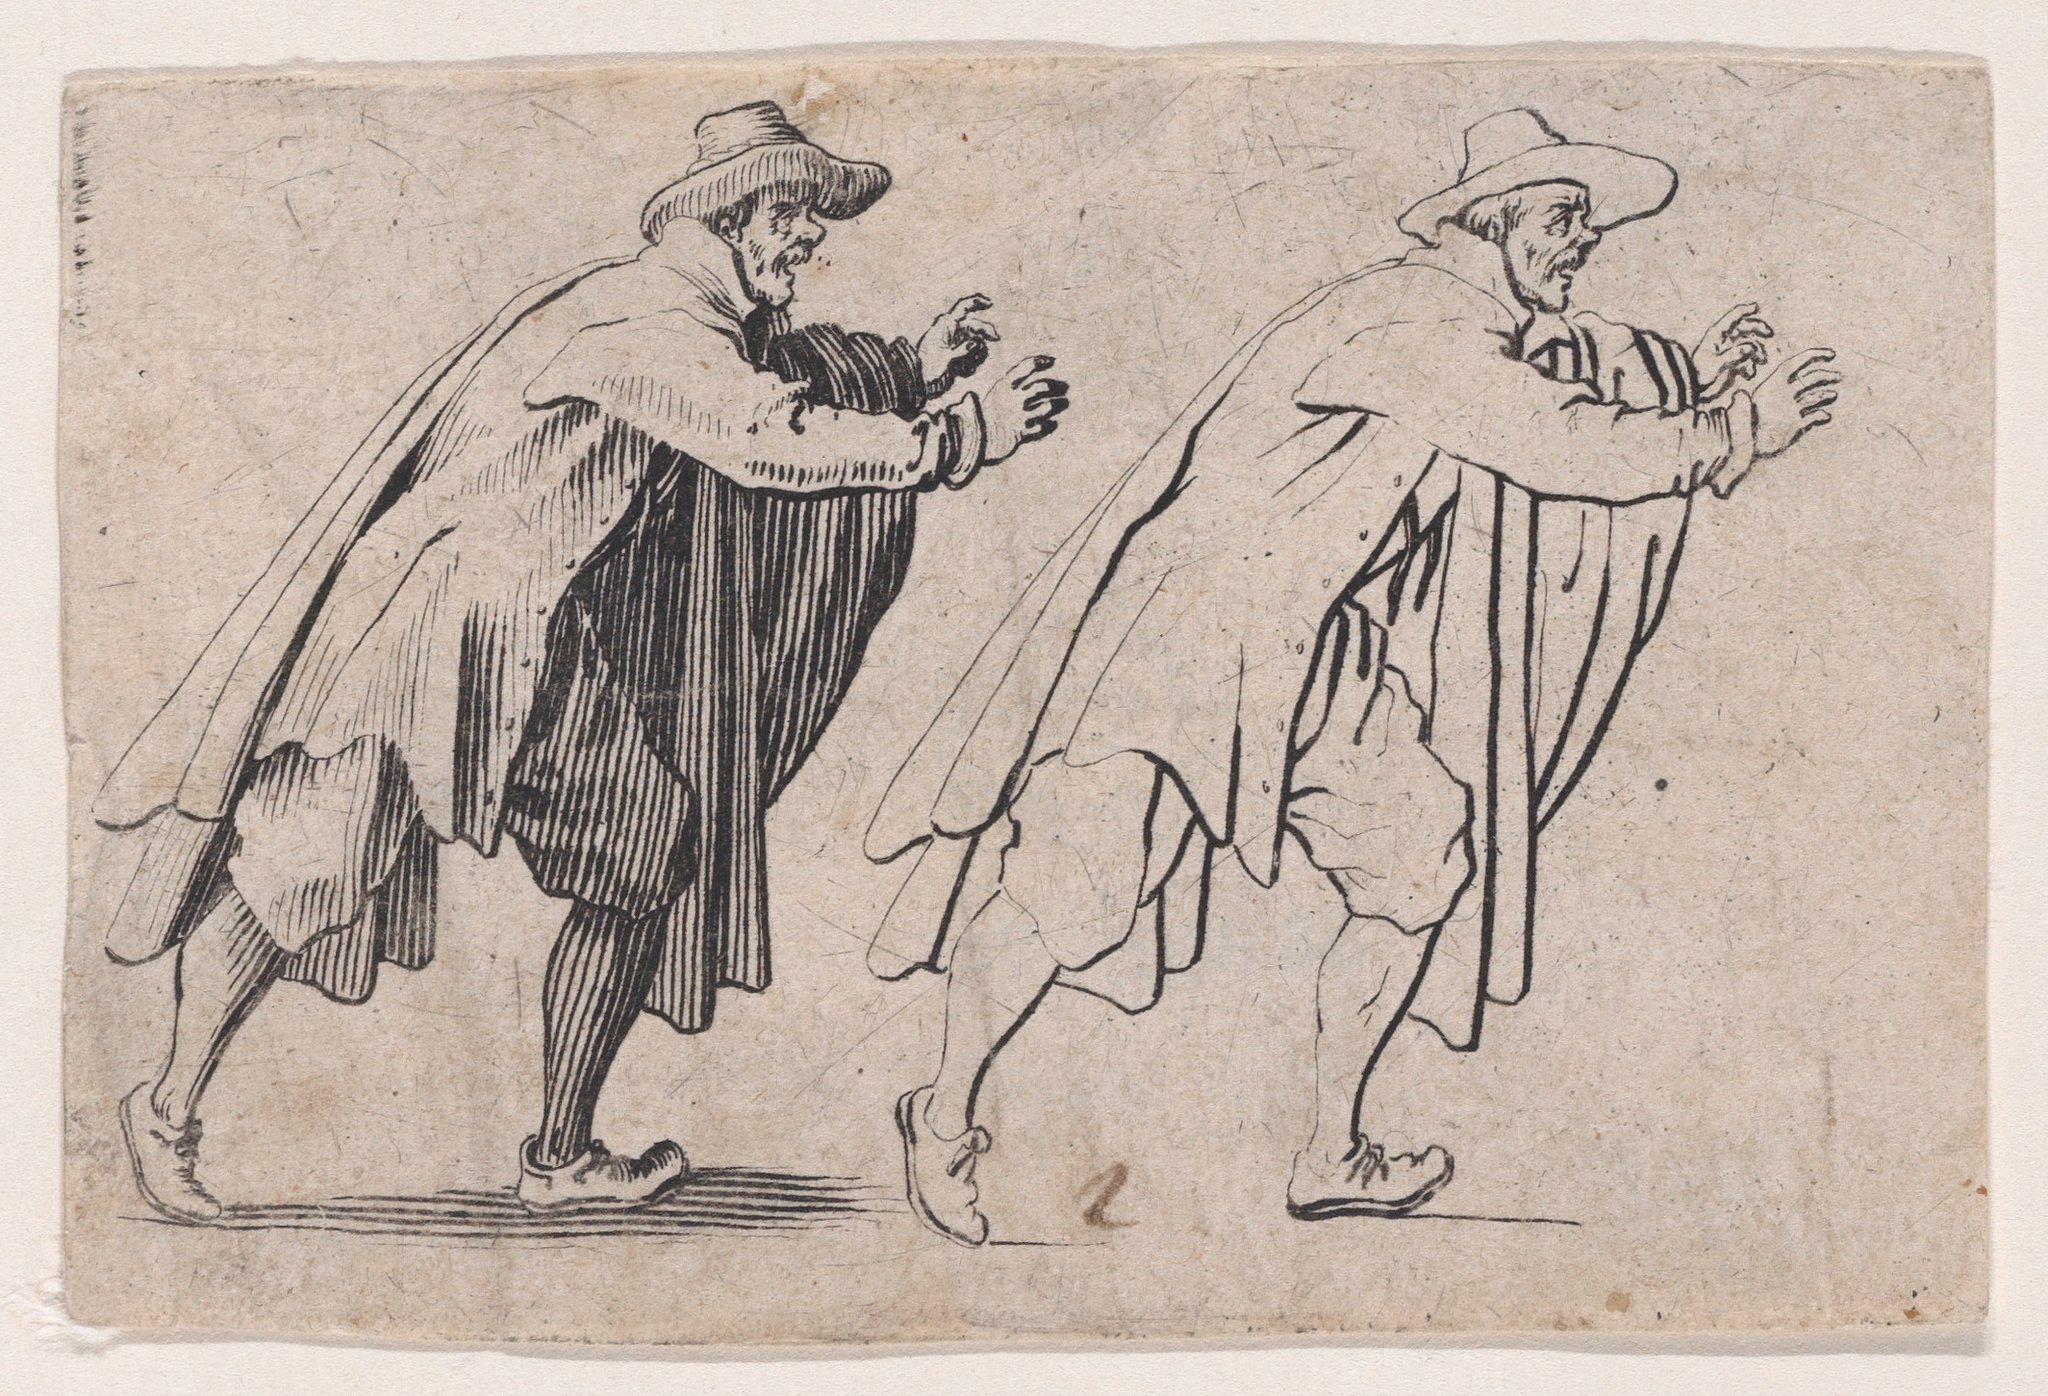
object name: print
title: L'Homme qui Court (The Running Man), from Les Caprices Series B, The Nancy Set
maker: jacques callot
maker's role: artist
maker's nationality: french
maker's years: 1592-1635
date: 1617-1620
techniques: etching